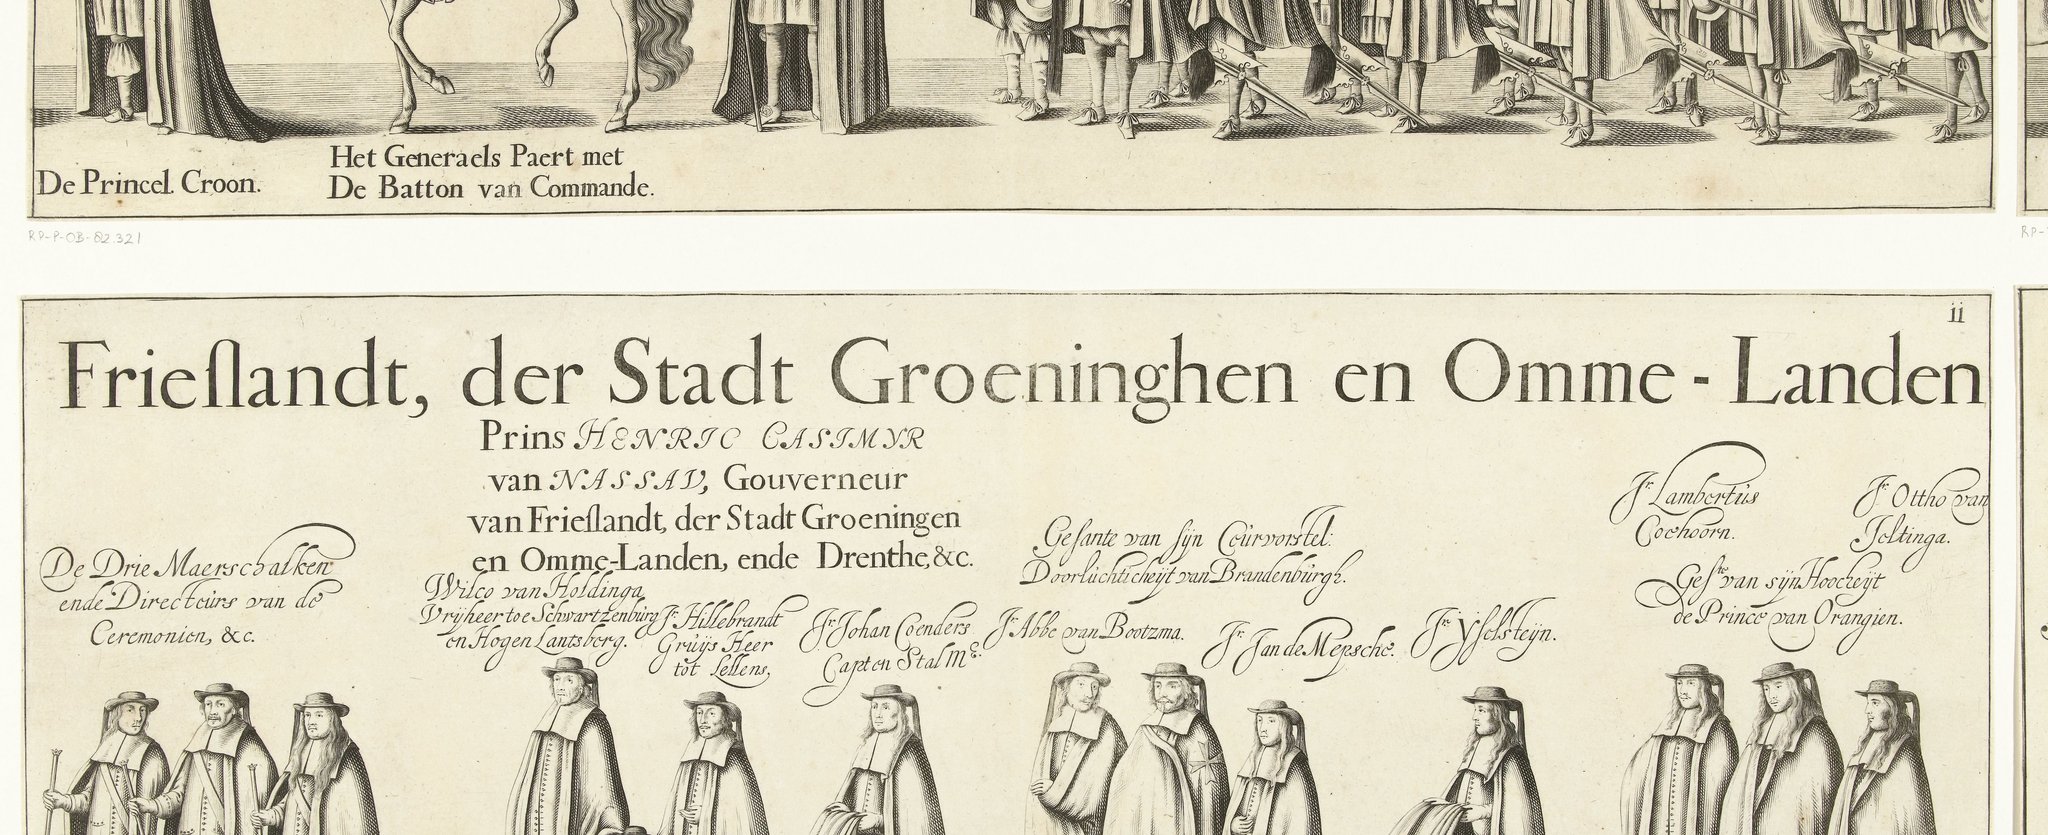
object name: print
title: Rouw-Staetelijcke Lijk-pracht in de Uyt-Vaert en Begraefenisse van het ont-zielde Lichaem van (...) Wilhelm Frederich (...) Overleden binnen Leeuwarden (...) den een-en-twintichsten October, MDCLXIV. en aldaer in 't Choor van de Jacobijner Kerck, den vyfthienden december MDCLXIV. Oude Stijl (...)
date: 1666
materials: paper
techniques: engraving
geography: leeuwarden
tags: arnhem, cortege, funeral procession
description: Begrafenisoptocht van Willem Frederik, graaf van Nassau-Dietz, in Leeuwarden op 6 januari 1665. Deel van de begrafenisstoet. Plaat nr. 11 in een ensemble van 24 (van de 25) ongemonteerde genummerde platen (zonder tekstbladen) die samen een lange fries vormen.